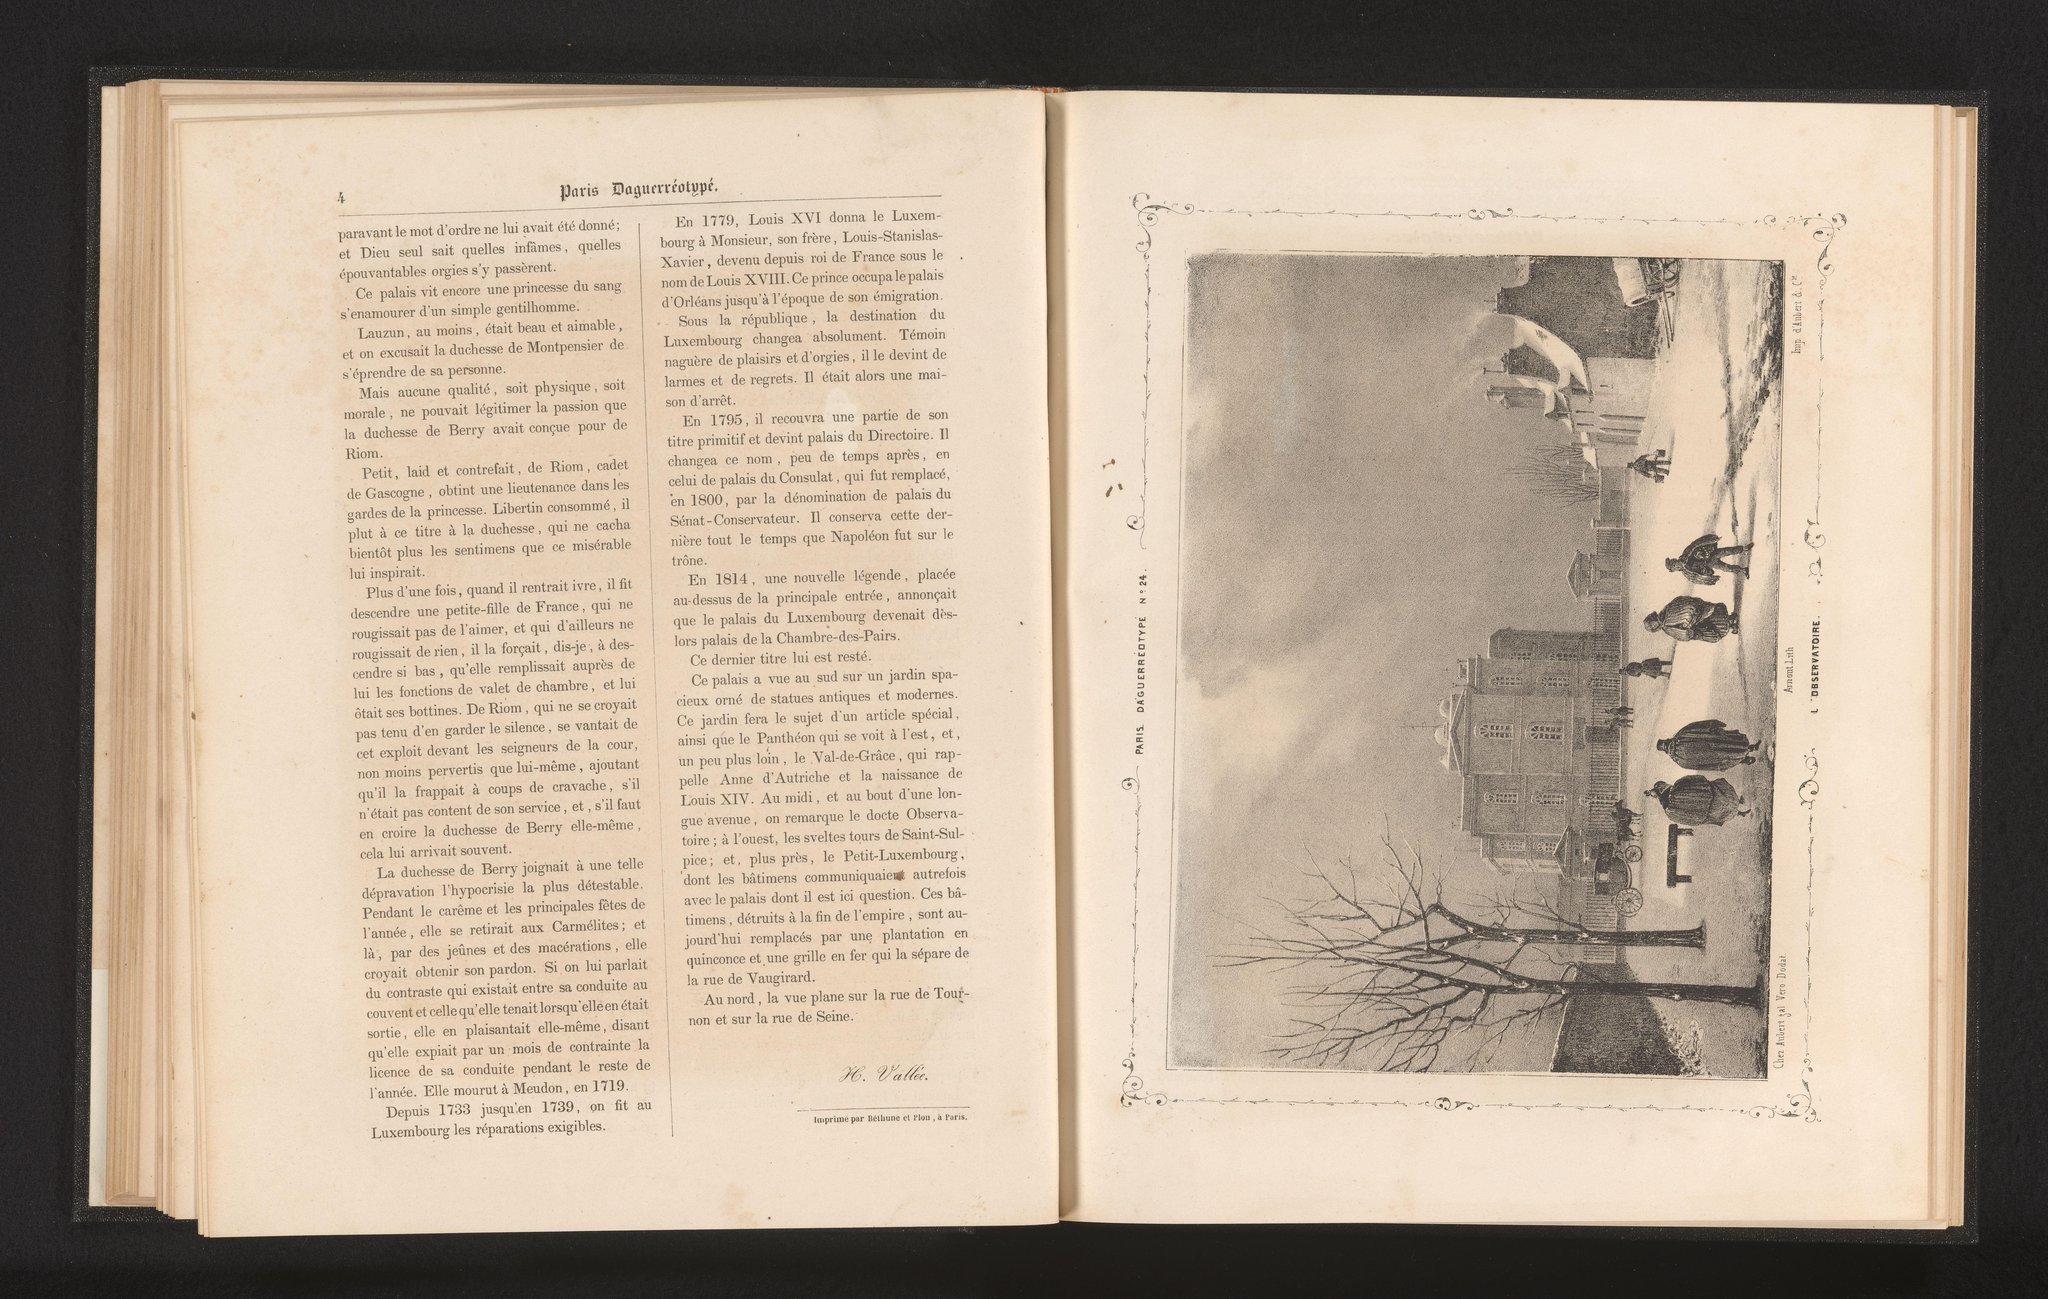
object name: page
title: l'Observatoire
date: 1839-1840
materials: paper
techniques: lithograph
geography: paris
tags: observatory (~ astronomy)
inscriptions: inscription: ‘PARIS DAGUERRÉOTYPÉ No. 24.’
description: Prent op vijfennegentigste ongenummerde pagina.